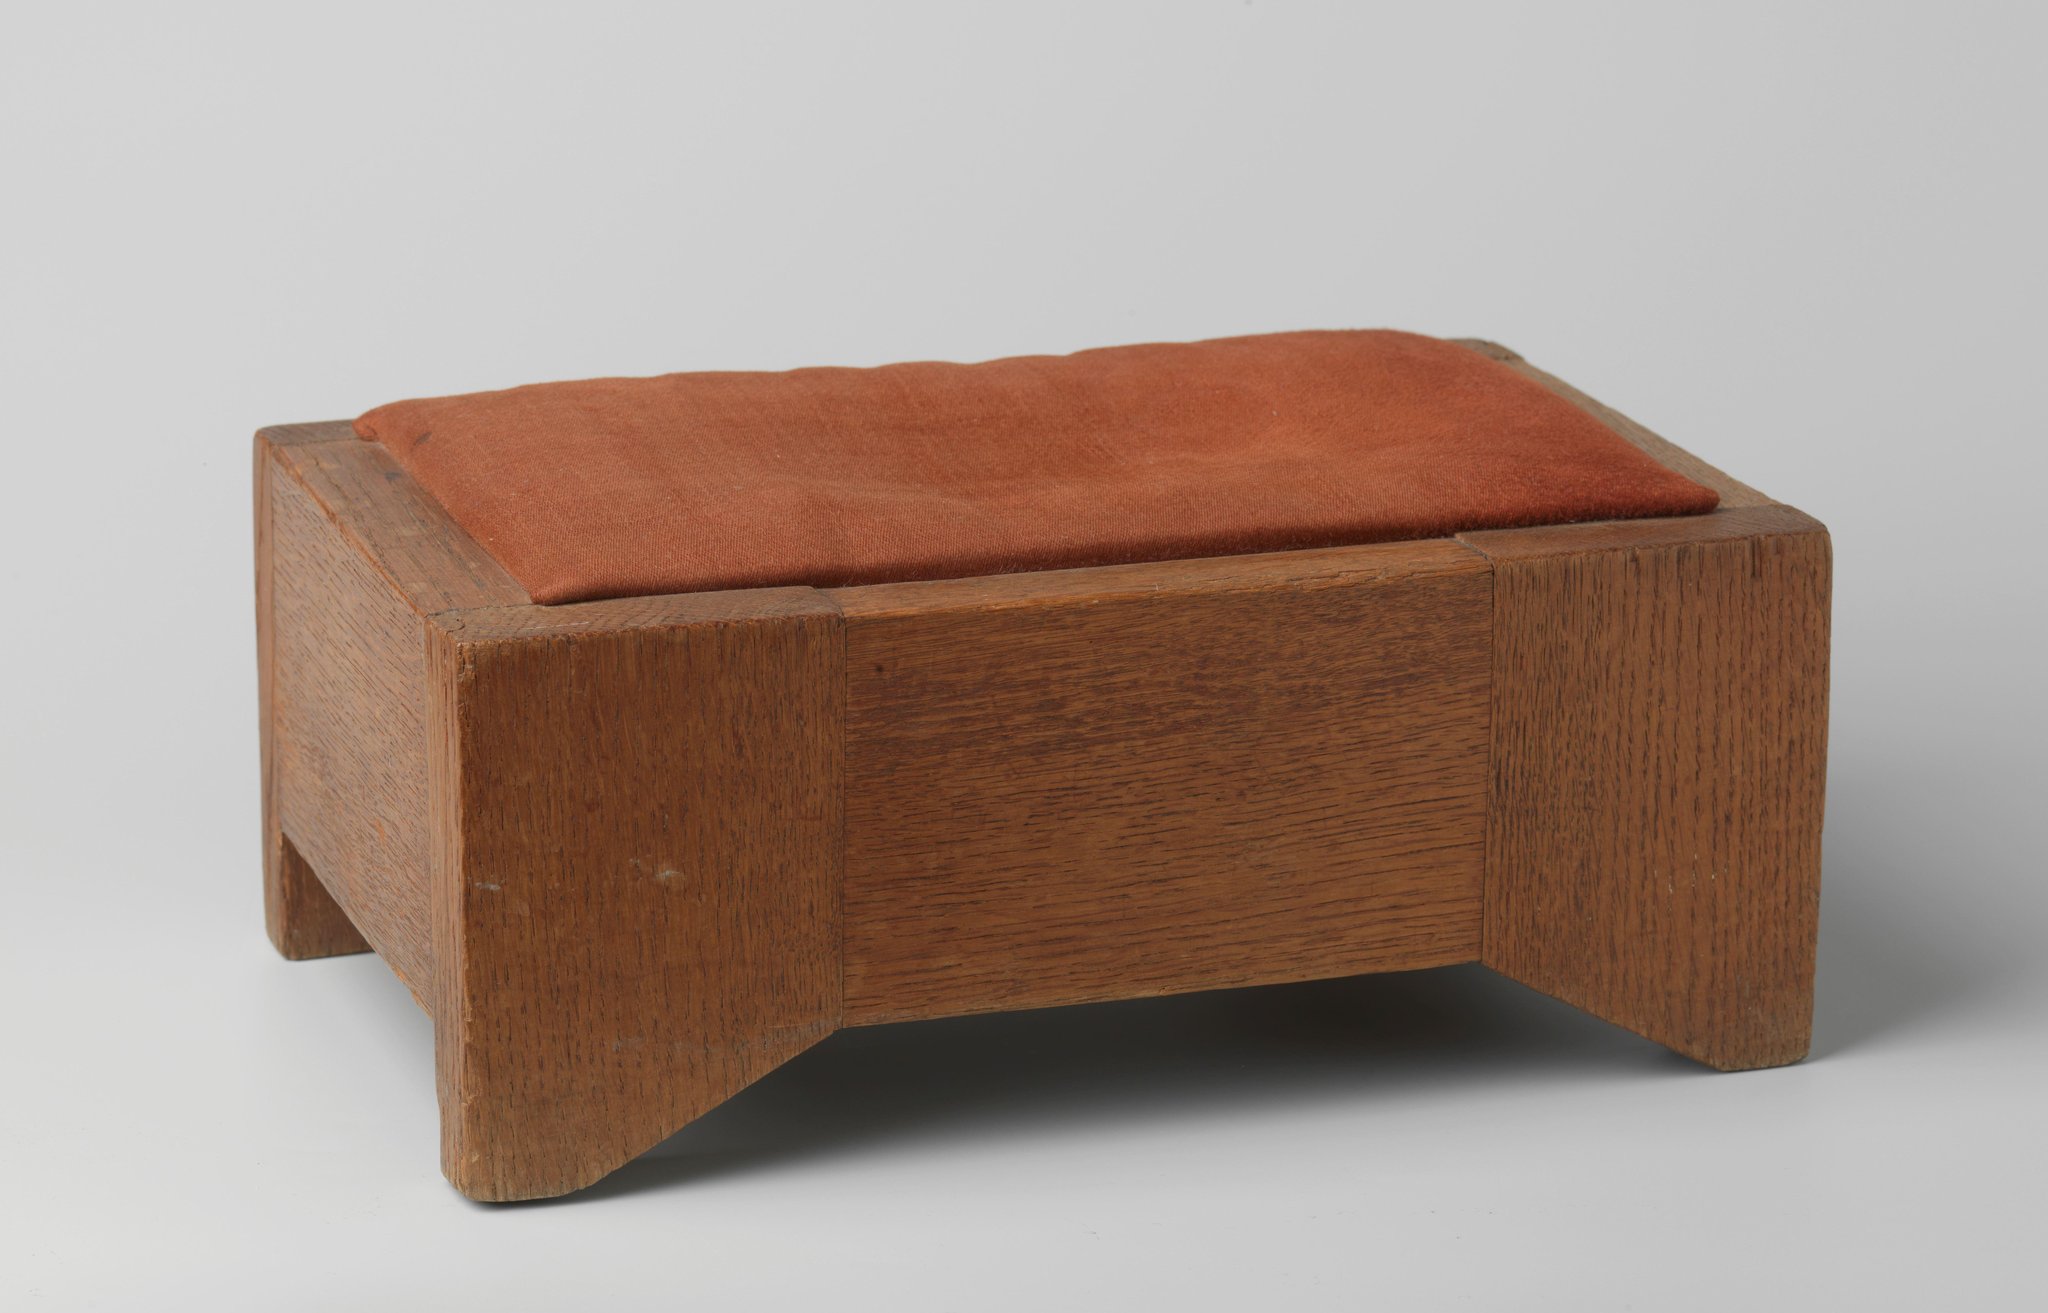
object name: footstool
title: Voetenbank bekleed met rode wol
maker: hendrik wouda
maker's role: furniture worker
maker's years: 1885-1946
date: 1924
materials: wood, wool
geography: the hague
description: Het voetenbankje hoort bij het ensemble uit 1924, ontworpen door Hendrik Wouda en vervaardigd door H. Pander & Zonen, dat in 1973 door de heer en mevrouw Hanson-Peentstra is geschonken en in de collectie van het Rijksmuseum is opgenomen onder de objectnummers BK-1973-307-A en B, BK-1973-308-A en B, BK-1973-309-A t/m F en BK-1973-310-A en B. Het voetenbankje is een fraaie aanvulling op dit grote ensemble, dat een voorbeeld is van de Haagse art deco uit het Interbellum. In tegenstelling tot de andere meubelen is het nog bekleed met de originele stof waardoor het een belangrijk referentie-object is binnen dit ensemble.